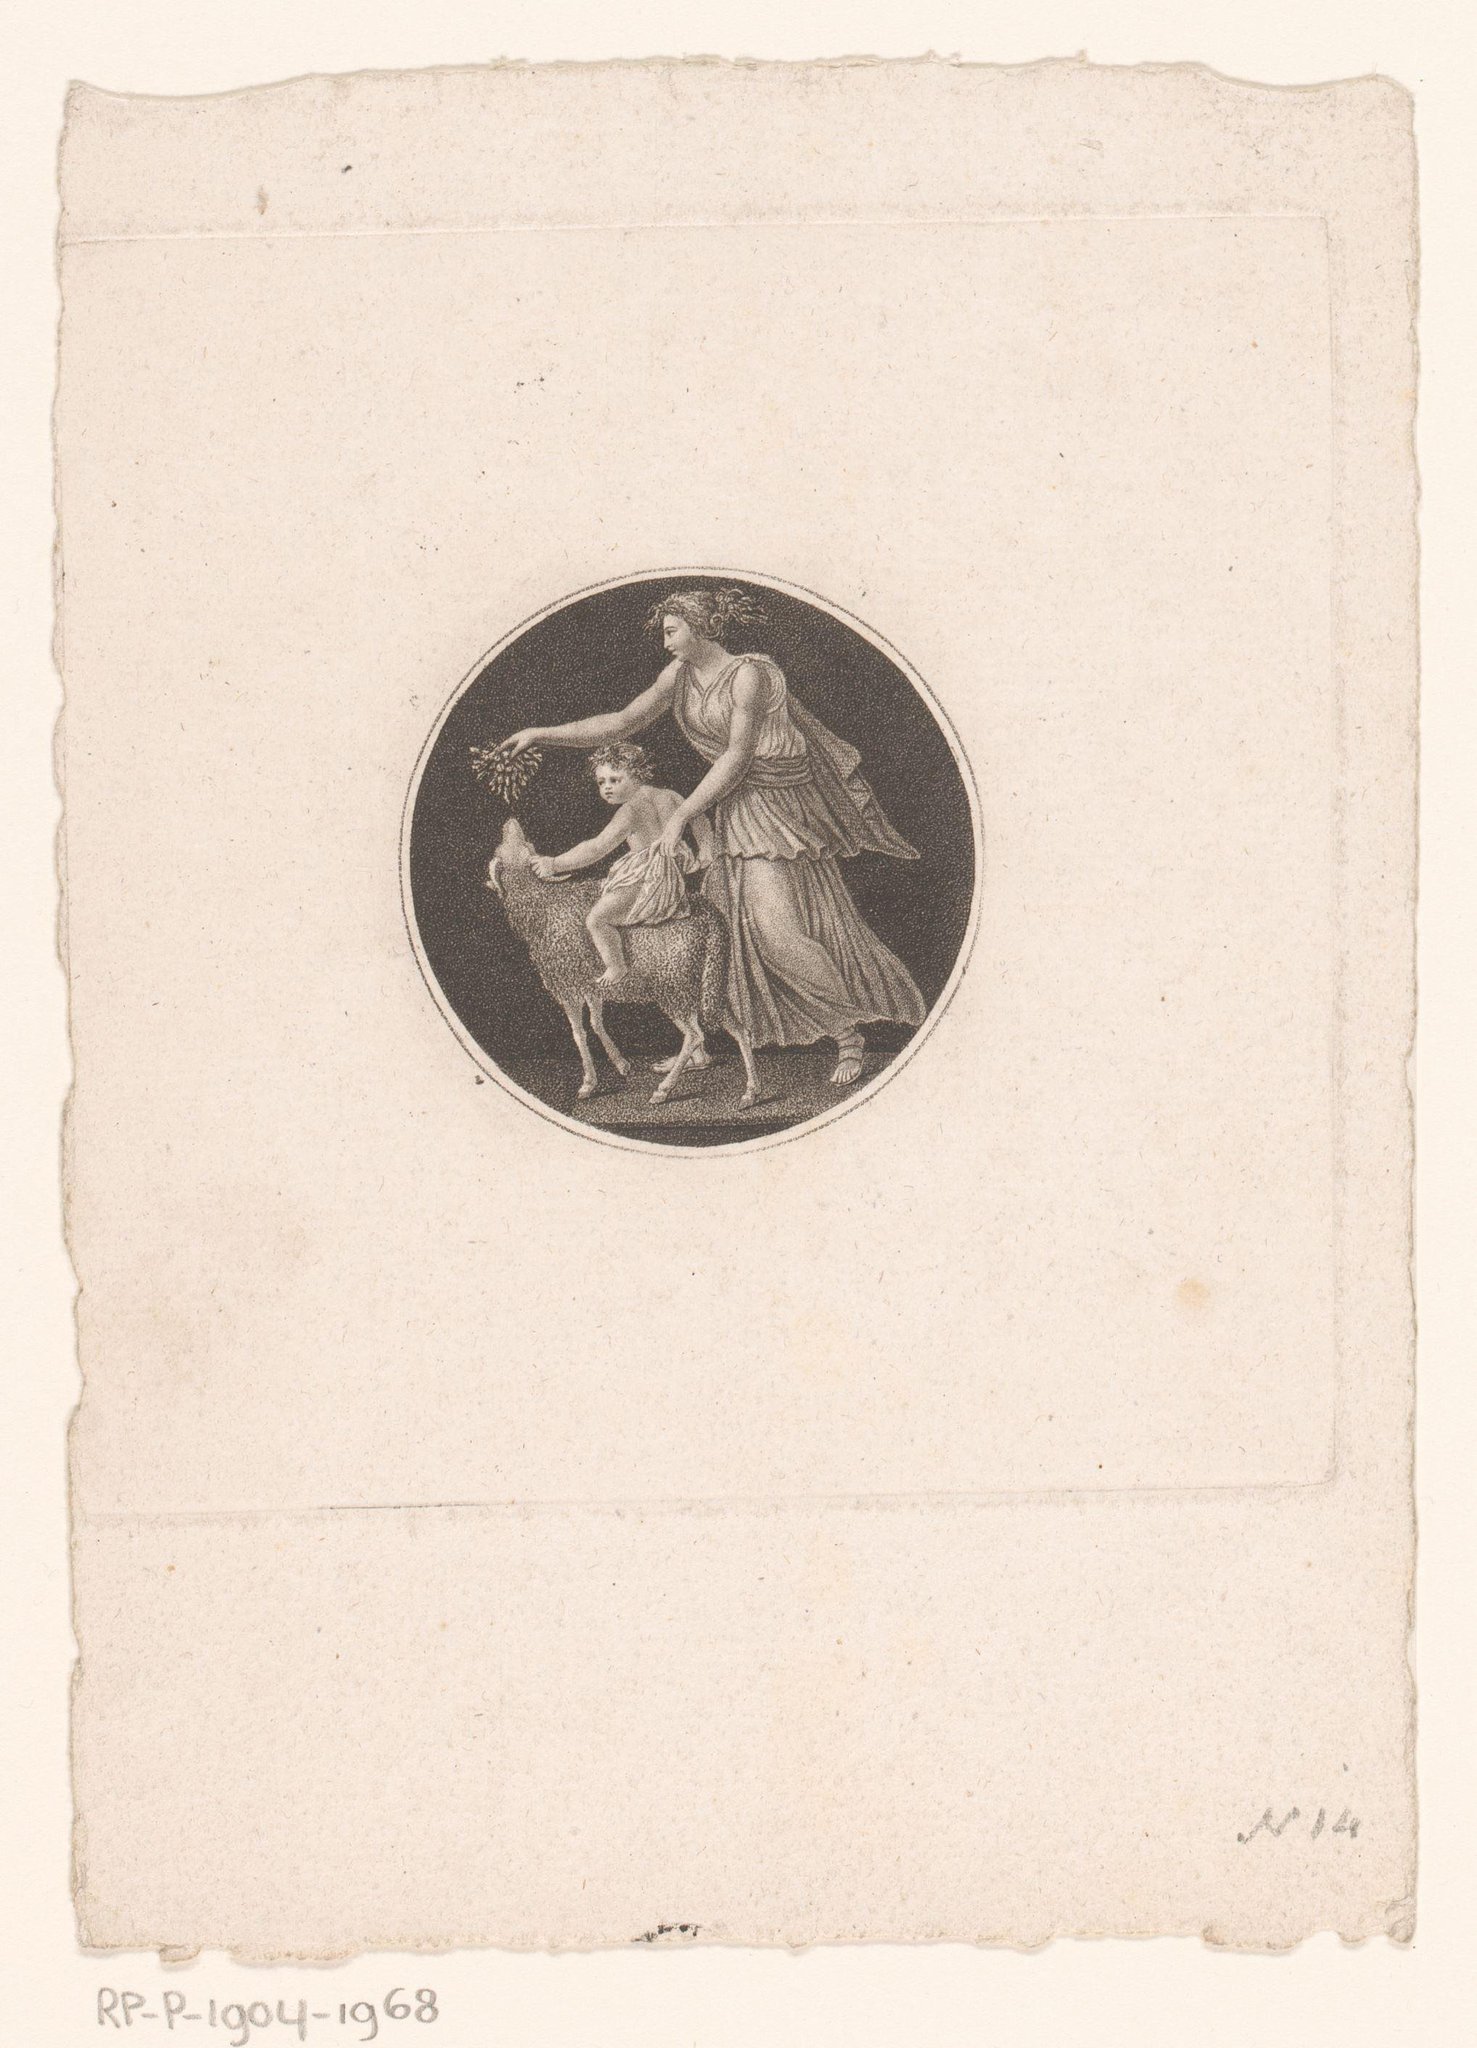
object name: print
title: Vrouw houdt kind vast dat op een schaap rijdt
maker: auguste sandoz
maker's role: print maker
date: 1760-1825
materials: paper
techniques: etching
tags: sheep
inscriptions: collector's mark: Lugt 2228